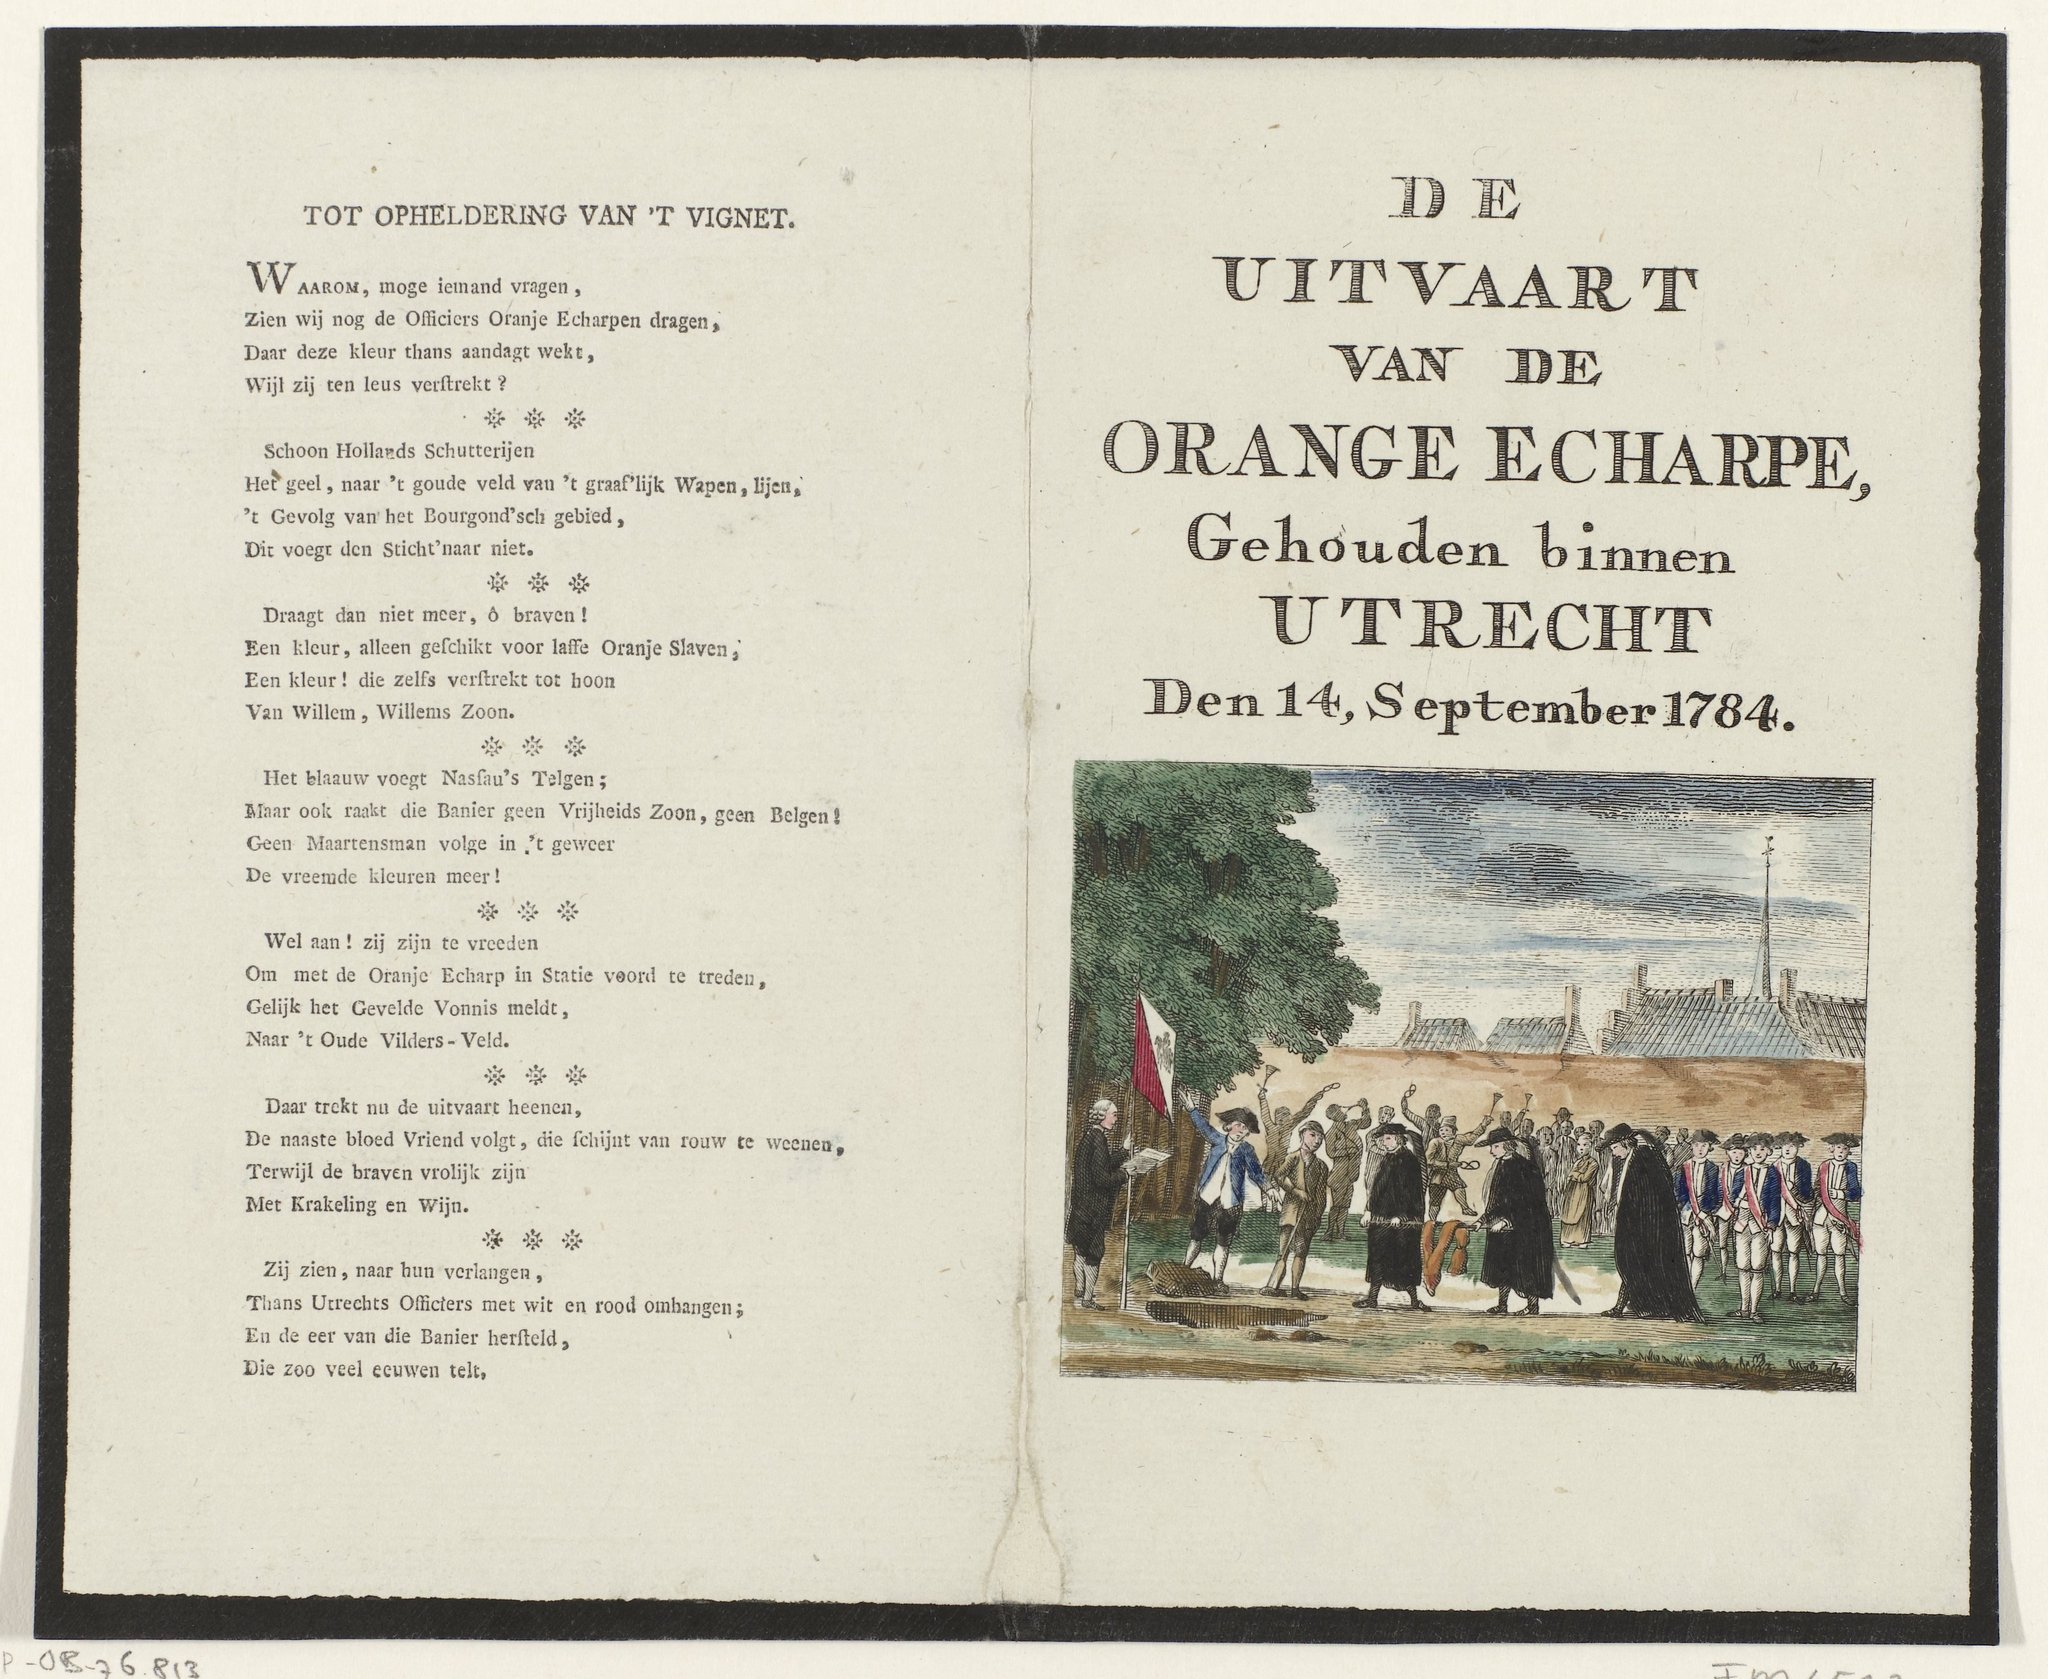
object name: cartoon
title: De Uitvaart van de Orange Echarpe, Gehouden binnen Utrecht Den 14, September 1784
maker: Anonymous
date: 1784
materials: paper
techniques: etching, hand coloring, letterpress printing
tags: burial, utrecht, patriots (1780-1795)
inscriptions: collector's mark: Lugt 2228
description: Spotprent in de vorm van een rouwkaart met een voorstelling van een Oranje écharpe (sjerp) die naar een gereedstaande kuil wordt gedragen om begraven te worden; achter hen een vrijkorps en juichende toeschouwers. Ernaast een vers met zeven coupletten met een verklaring van de voorstelling.